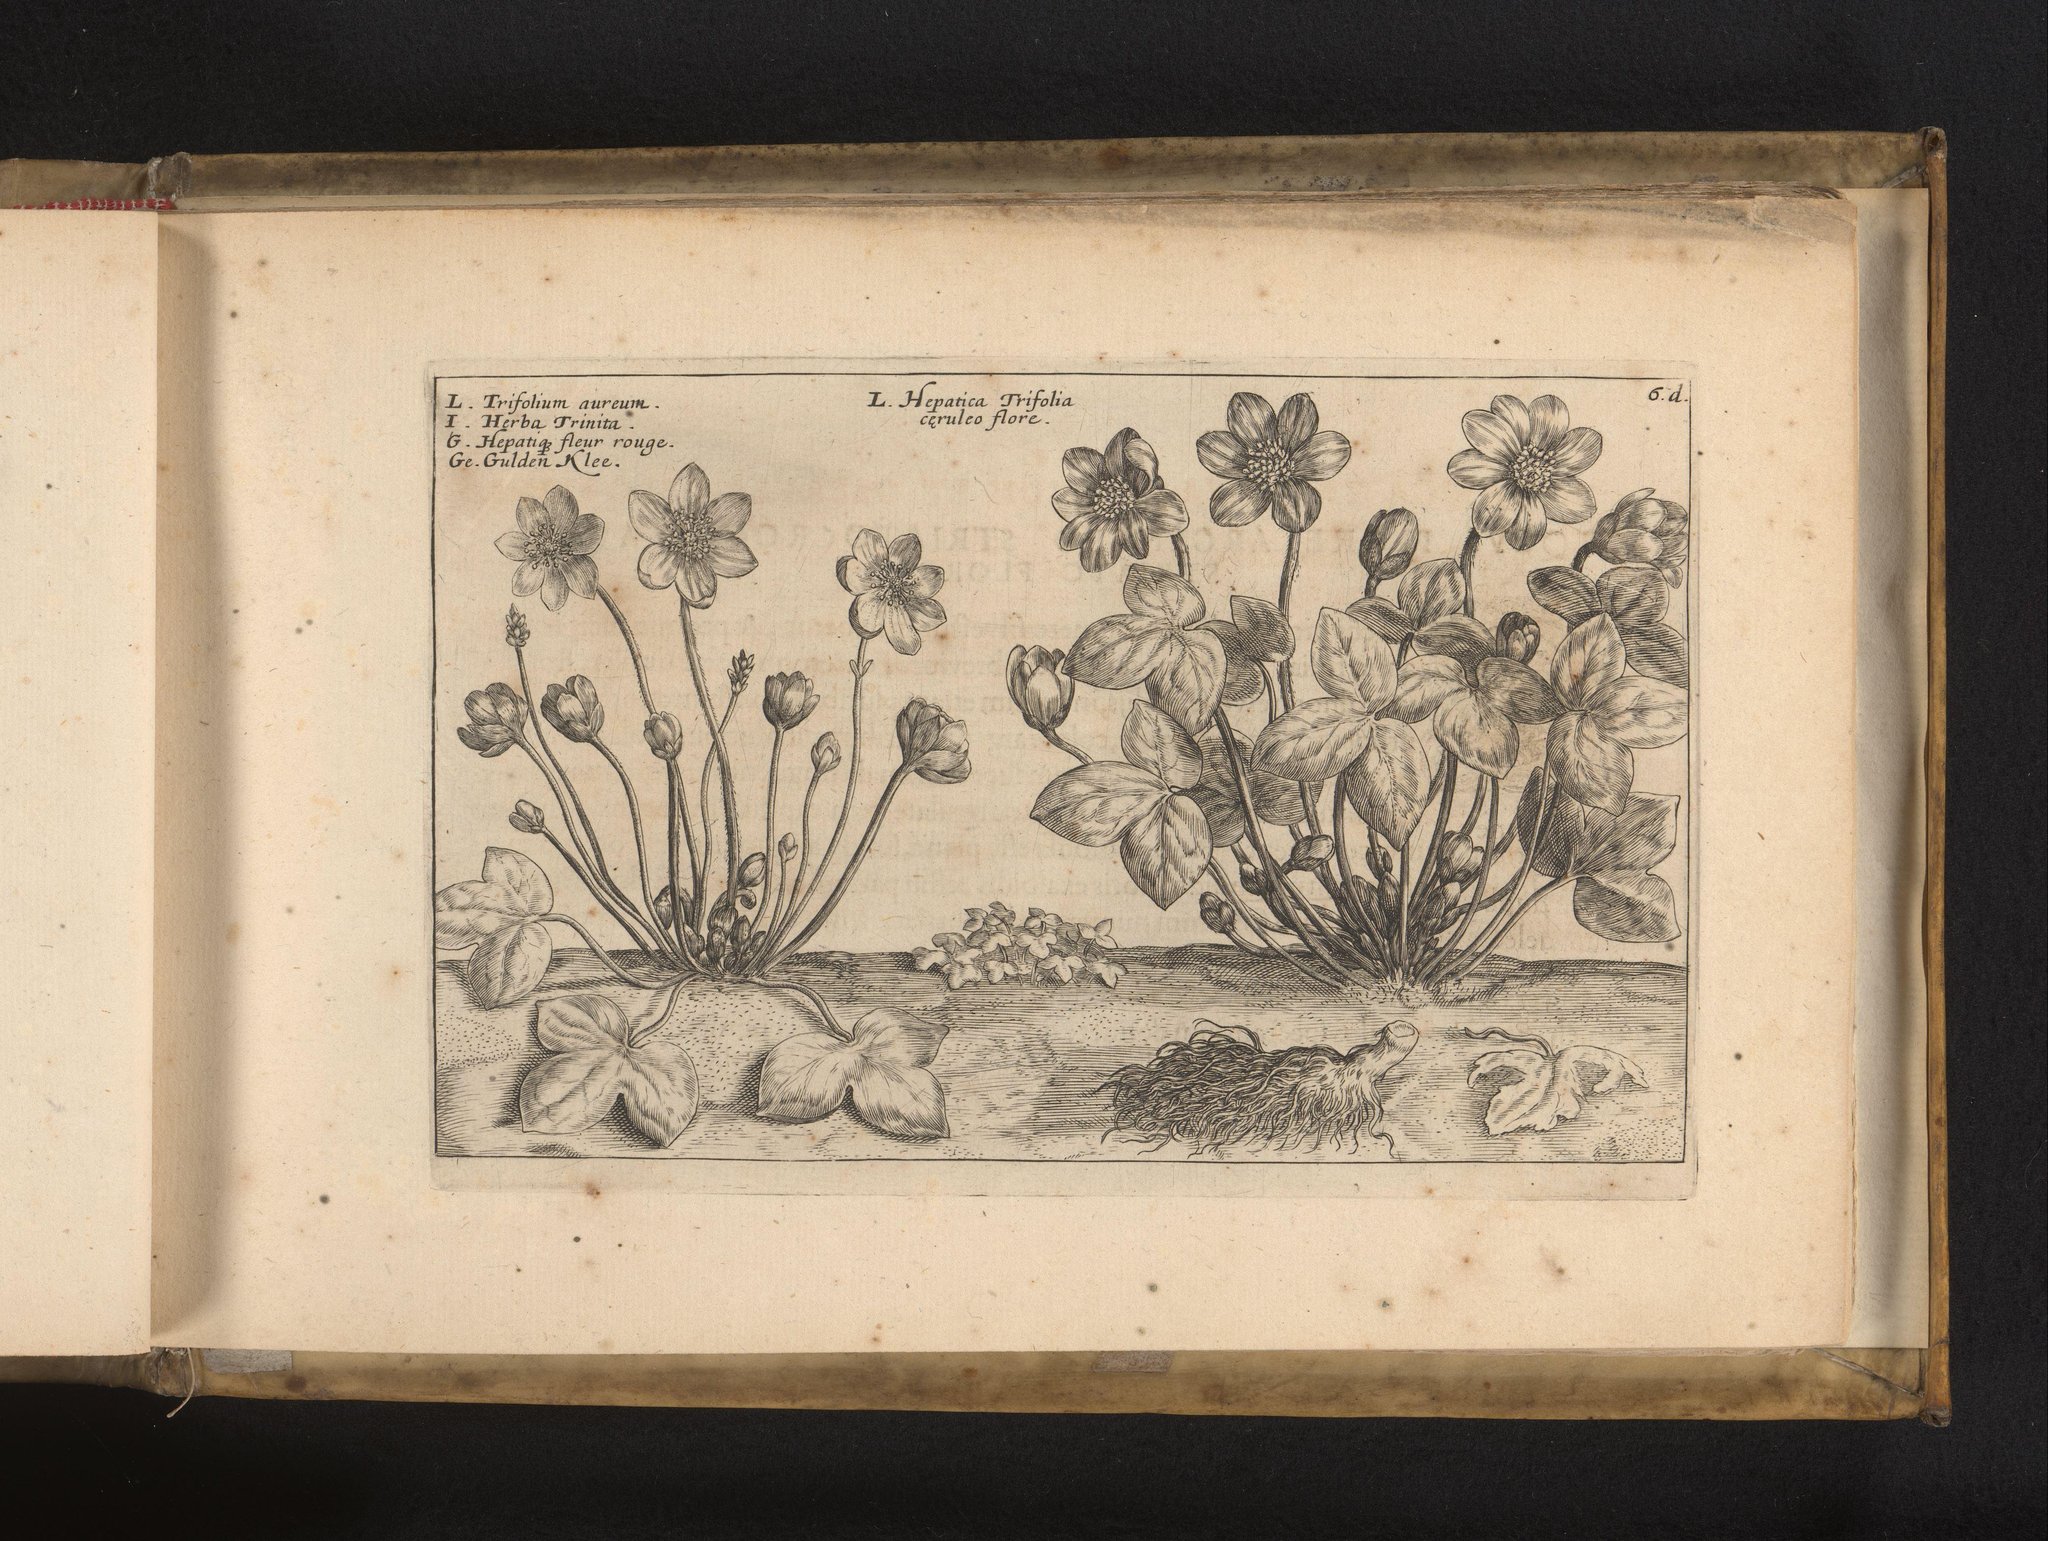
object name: book illustration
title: Hortus floridus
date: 1617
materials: paper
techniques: engraving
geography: utrecht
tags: flowers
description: Prent uit: Passe, Crispijn van de (II). Hortus floridus in quo rariorum & minus vulgarium florum icones ad vivam veramque formam. Arnhem: Johannes Janssonius, 1617.